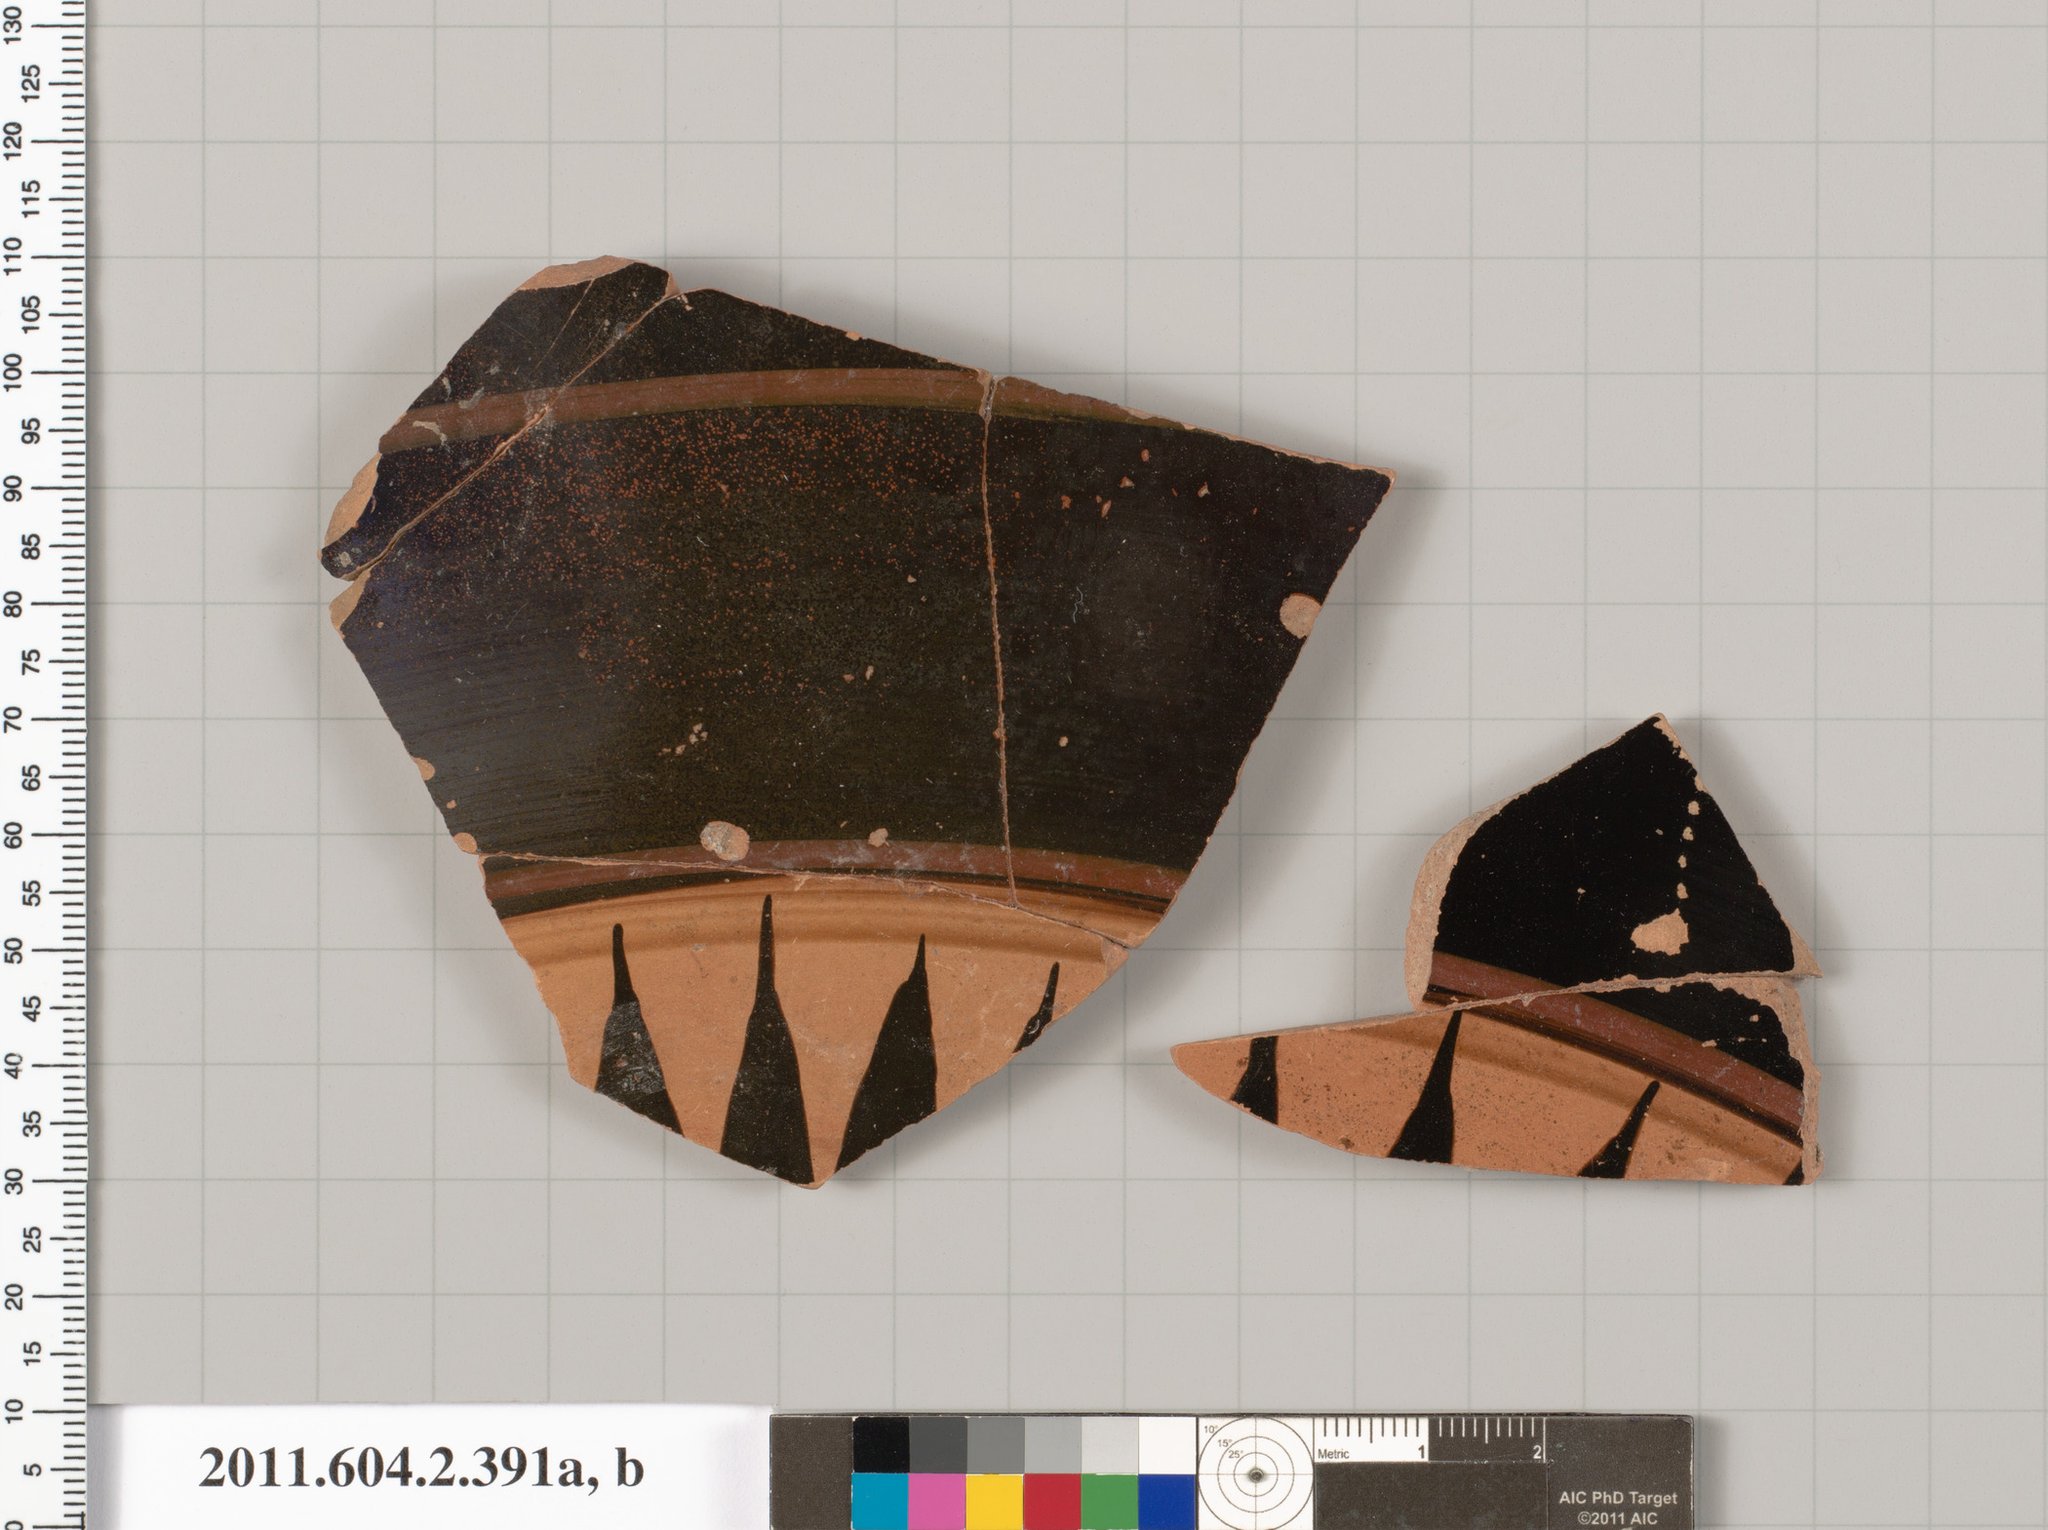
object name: column krater fragment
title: Terracotta fragments of a column-krater (bowl for mixing wine and water)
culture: greek, attic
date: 460-440 BCE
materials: terracotta